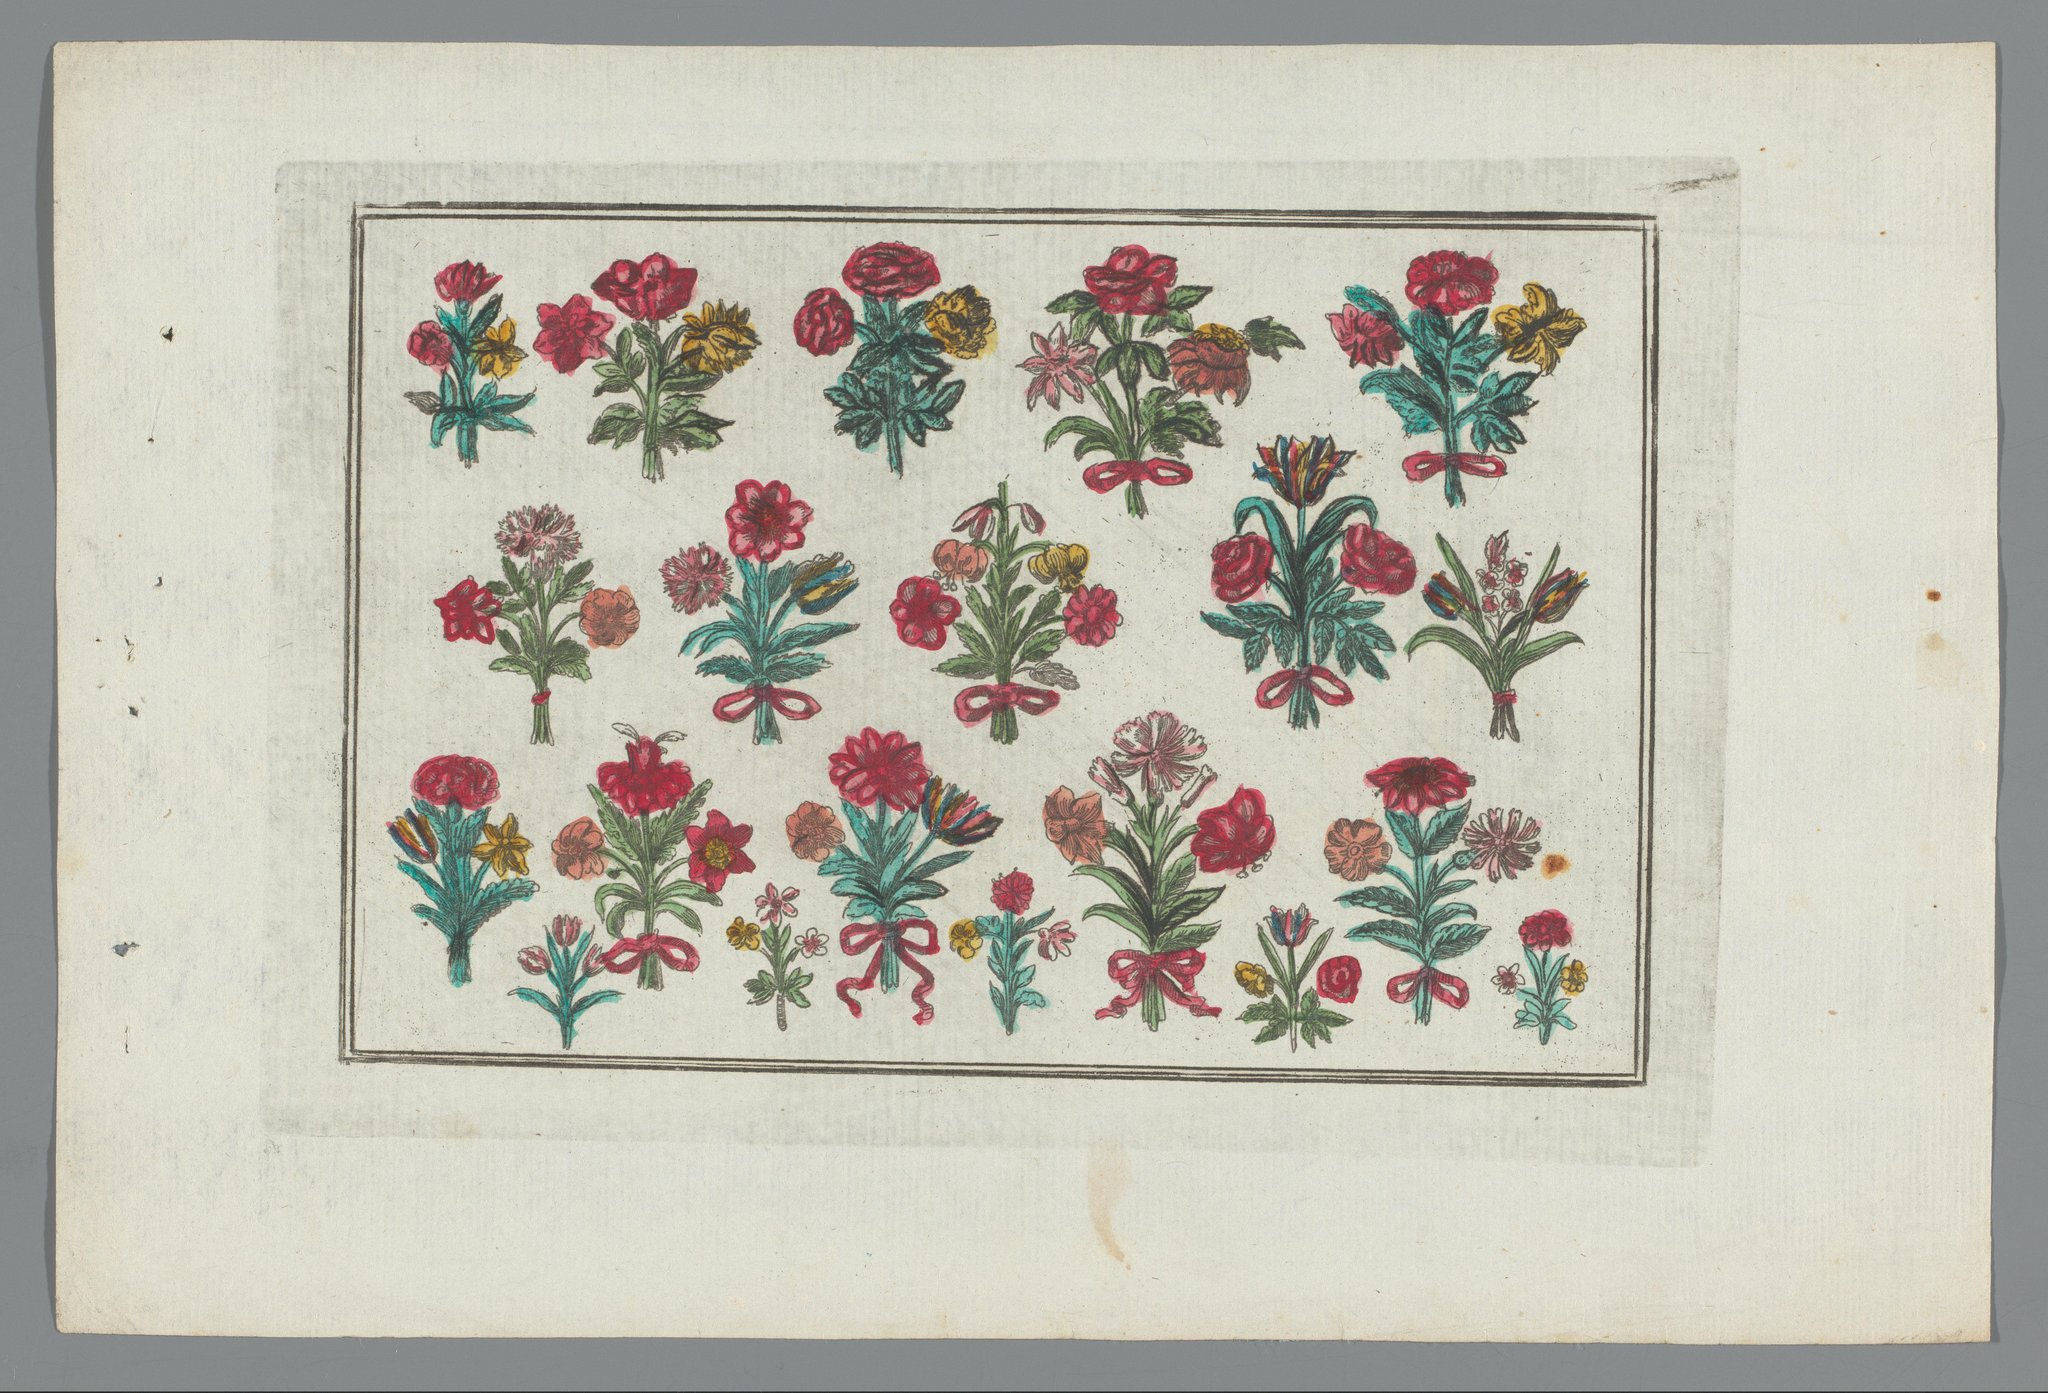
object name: print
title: Bladen met knipplaatjes en decoratieve randen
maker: Anonymous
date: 1750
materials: paper, watercolor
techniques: etching, hand coloring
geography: paris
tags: flowers, cut flowers; nosegay, bunch of flowers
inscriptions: collector's mark: Lugt 2760, collector's mark: Lugt 2228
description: Drie rijen met grote en kleine boeketten, deels gebonden met een strik. Een van 39 bladen met knipplaatjes en decoratieve randen.